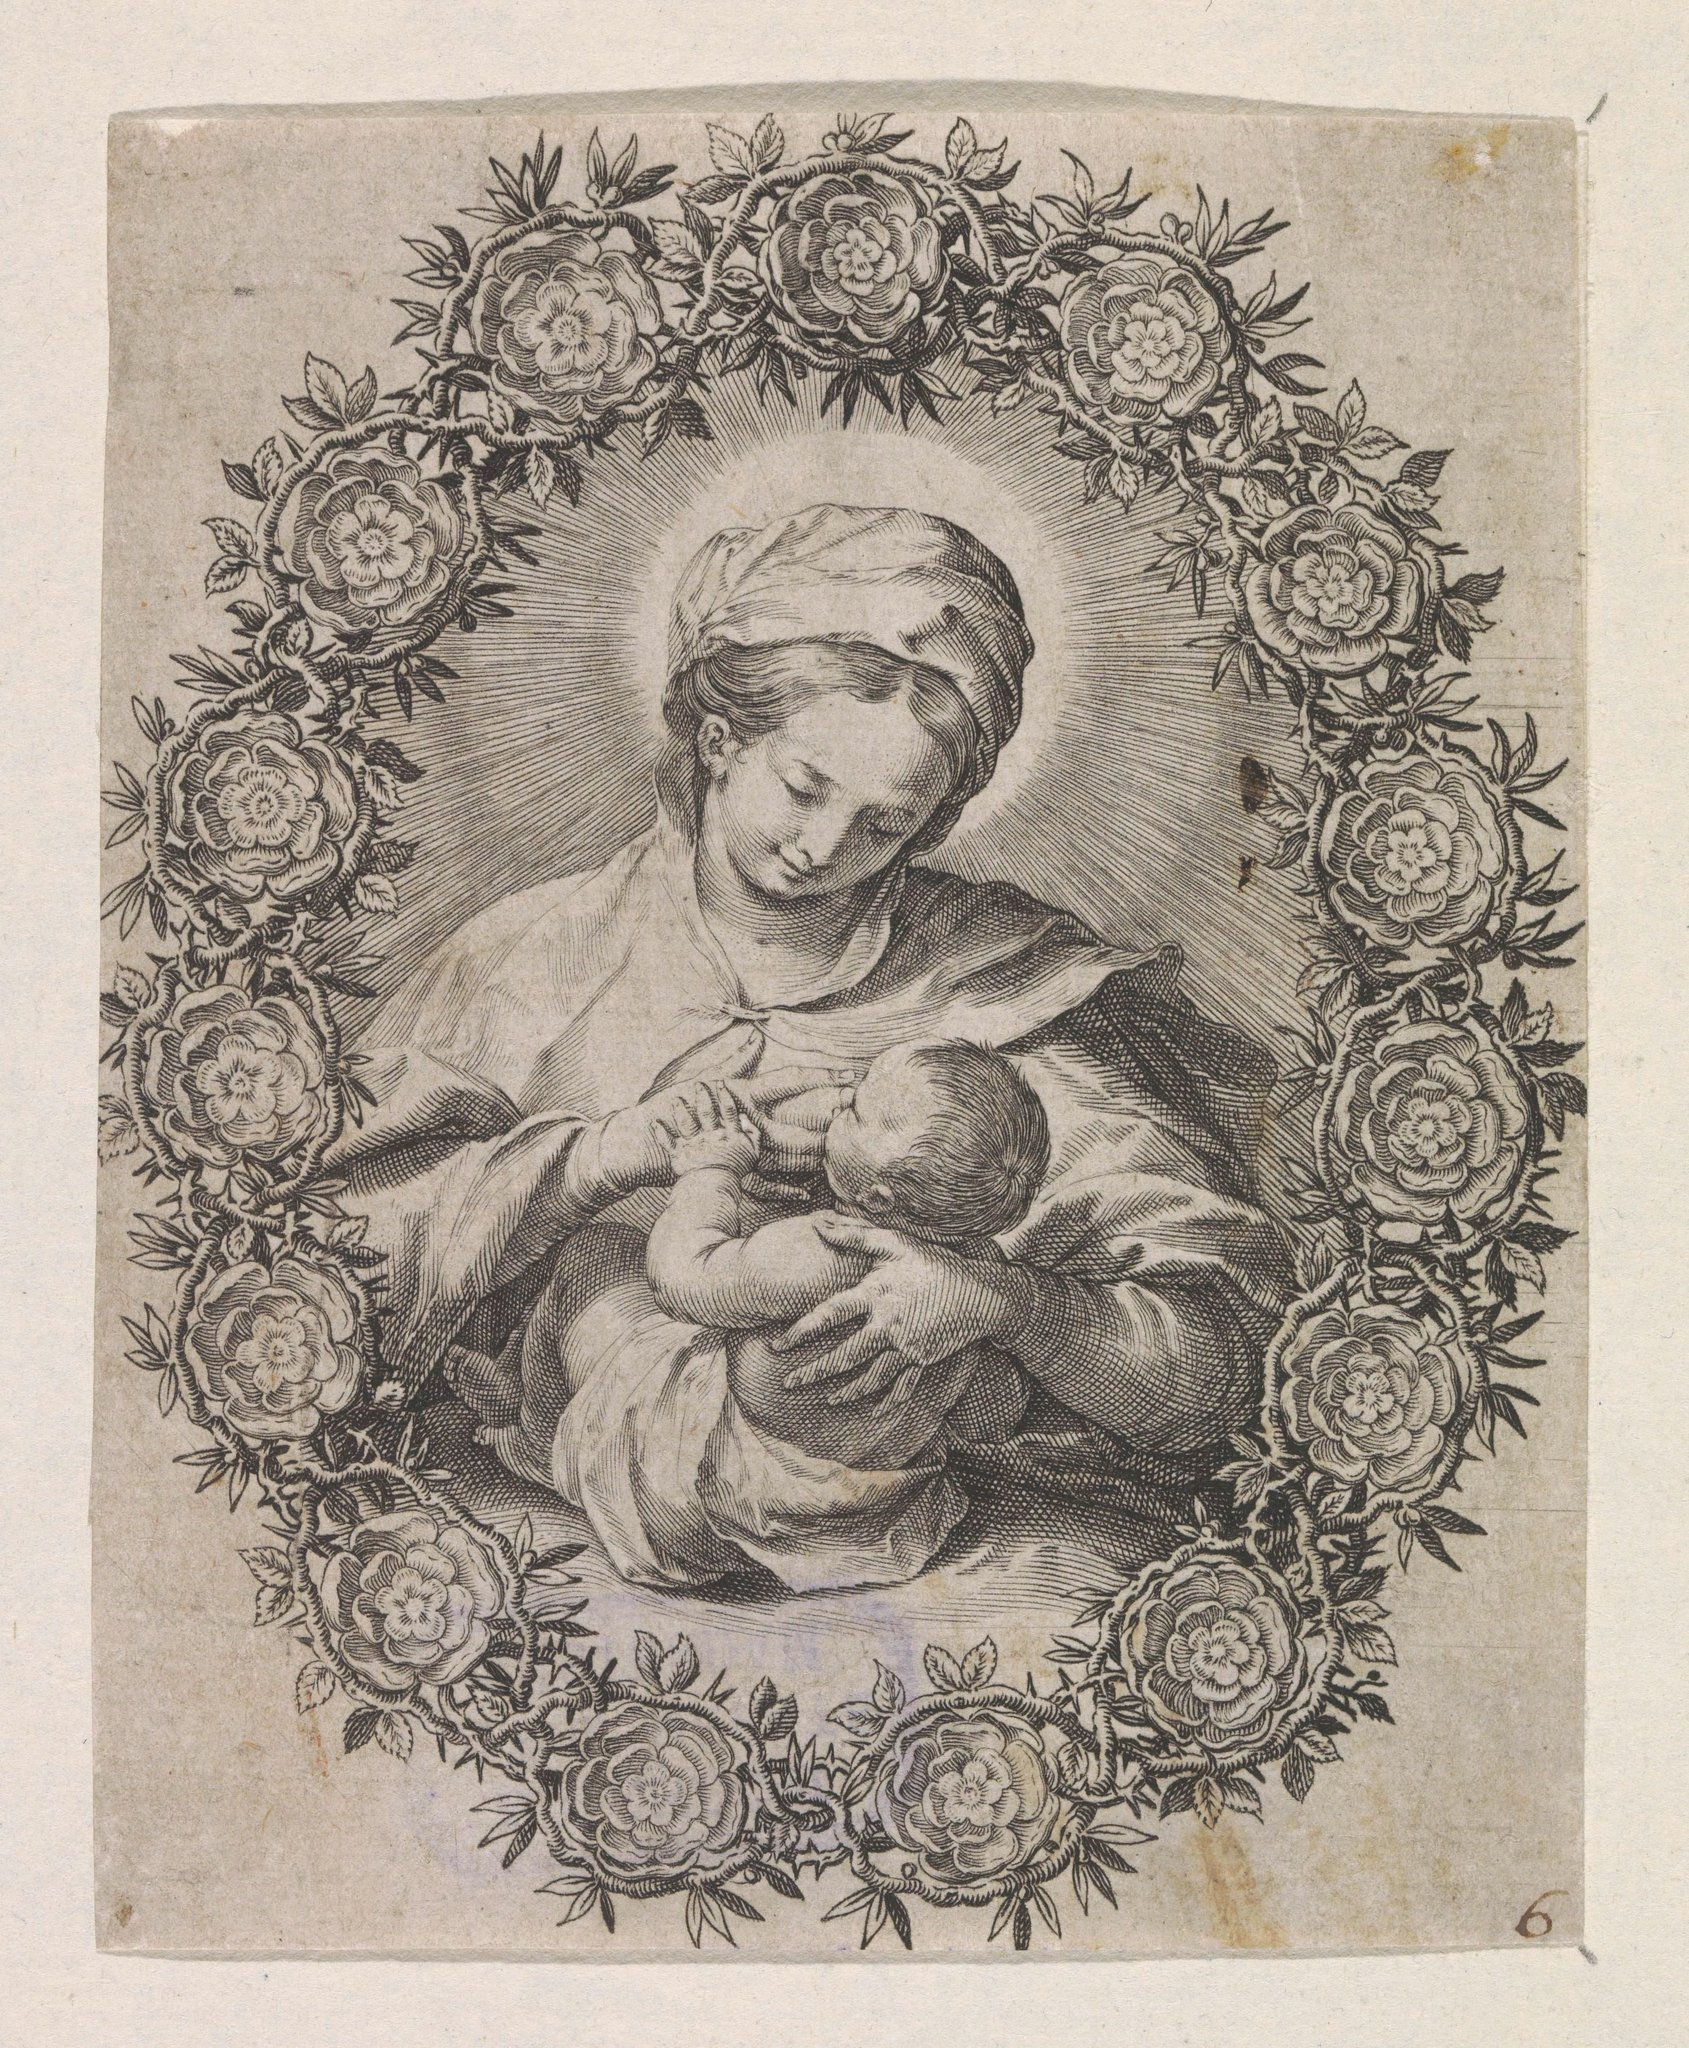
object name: print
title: Maria zoogt het Christuskind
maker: raphaël sadeler (i)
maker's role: print maker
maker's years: 1560-1628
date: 1570-1628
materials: paper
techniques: engraving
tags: christ-child suckling, or beginning to suckle, e.g. mary uncovering her breast ~ madonna-representations, flowers: rose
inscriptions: collector's mark: Lugt 10, number: ‘6’, collector's mark: Lugt 11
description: De maagd Maria zoogt het Christuskind. Rondom hen een krans van rozen.